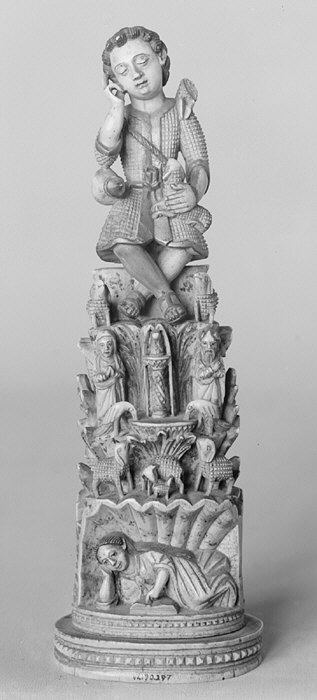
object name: statuette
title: Good Shepherd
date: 1601-1800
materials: ivory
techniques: gilding, polychromy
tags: animals,birds,buddha,virgin mary,shepherds